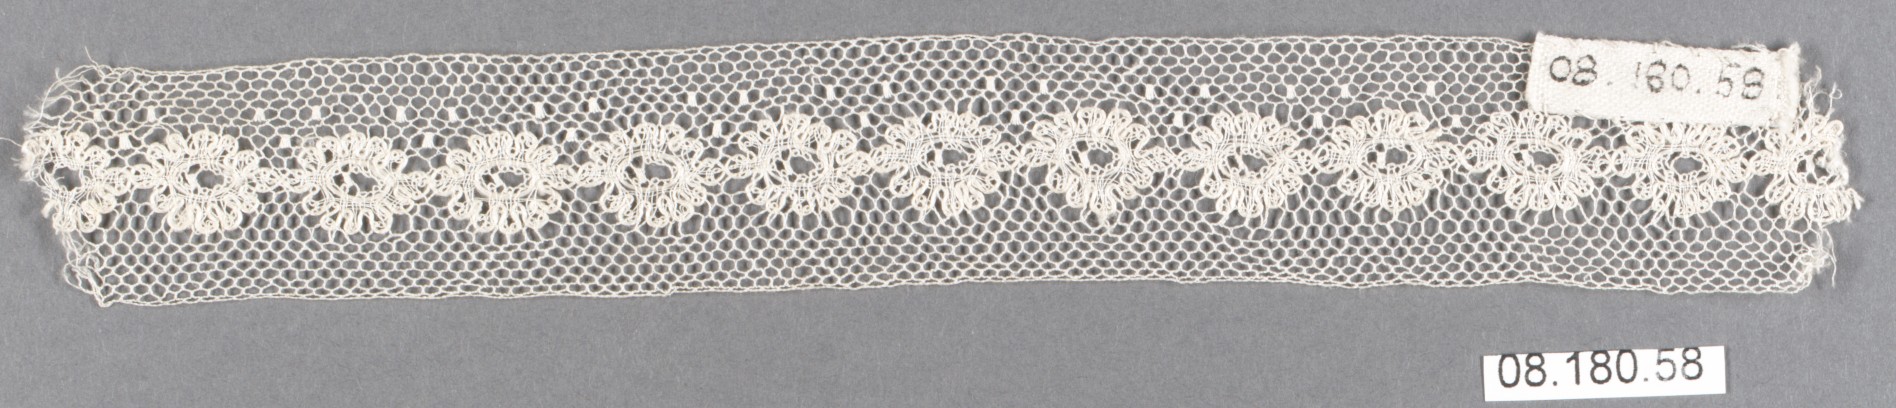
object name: baby lace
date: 1801-1900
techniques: lace